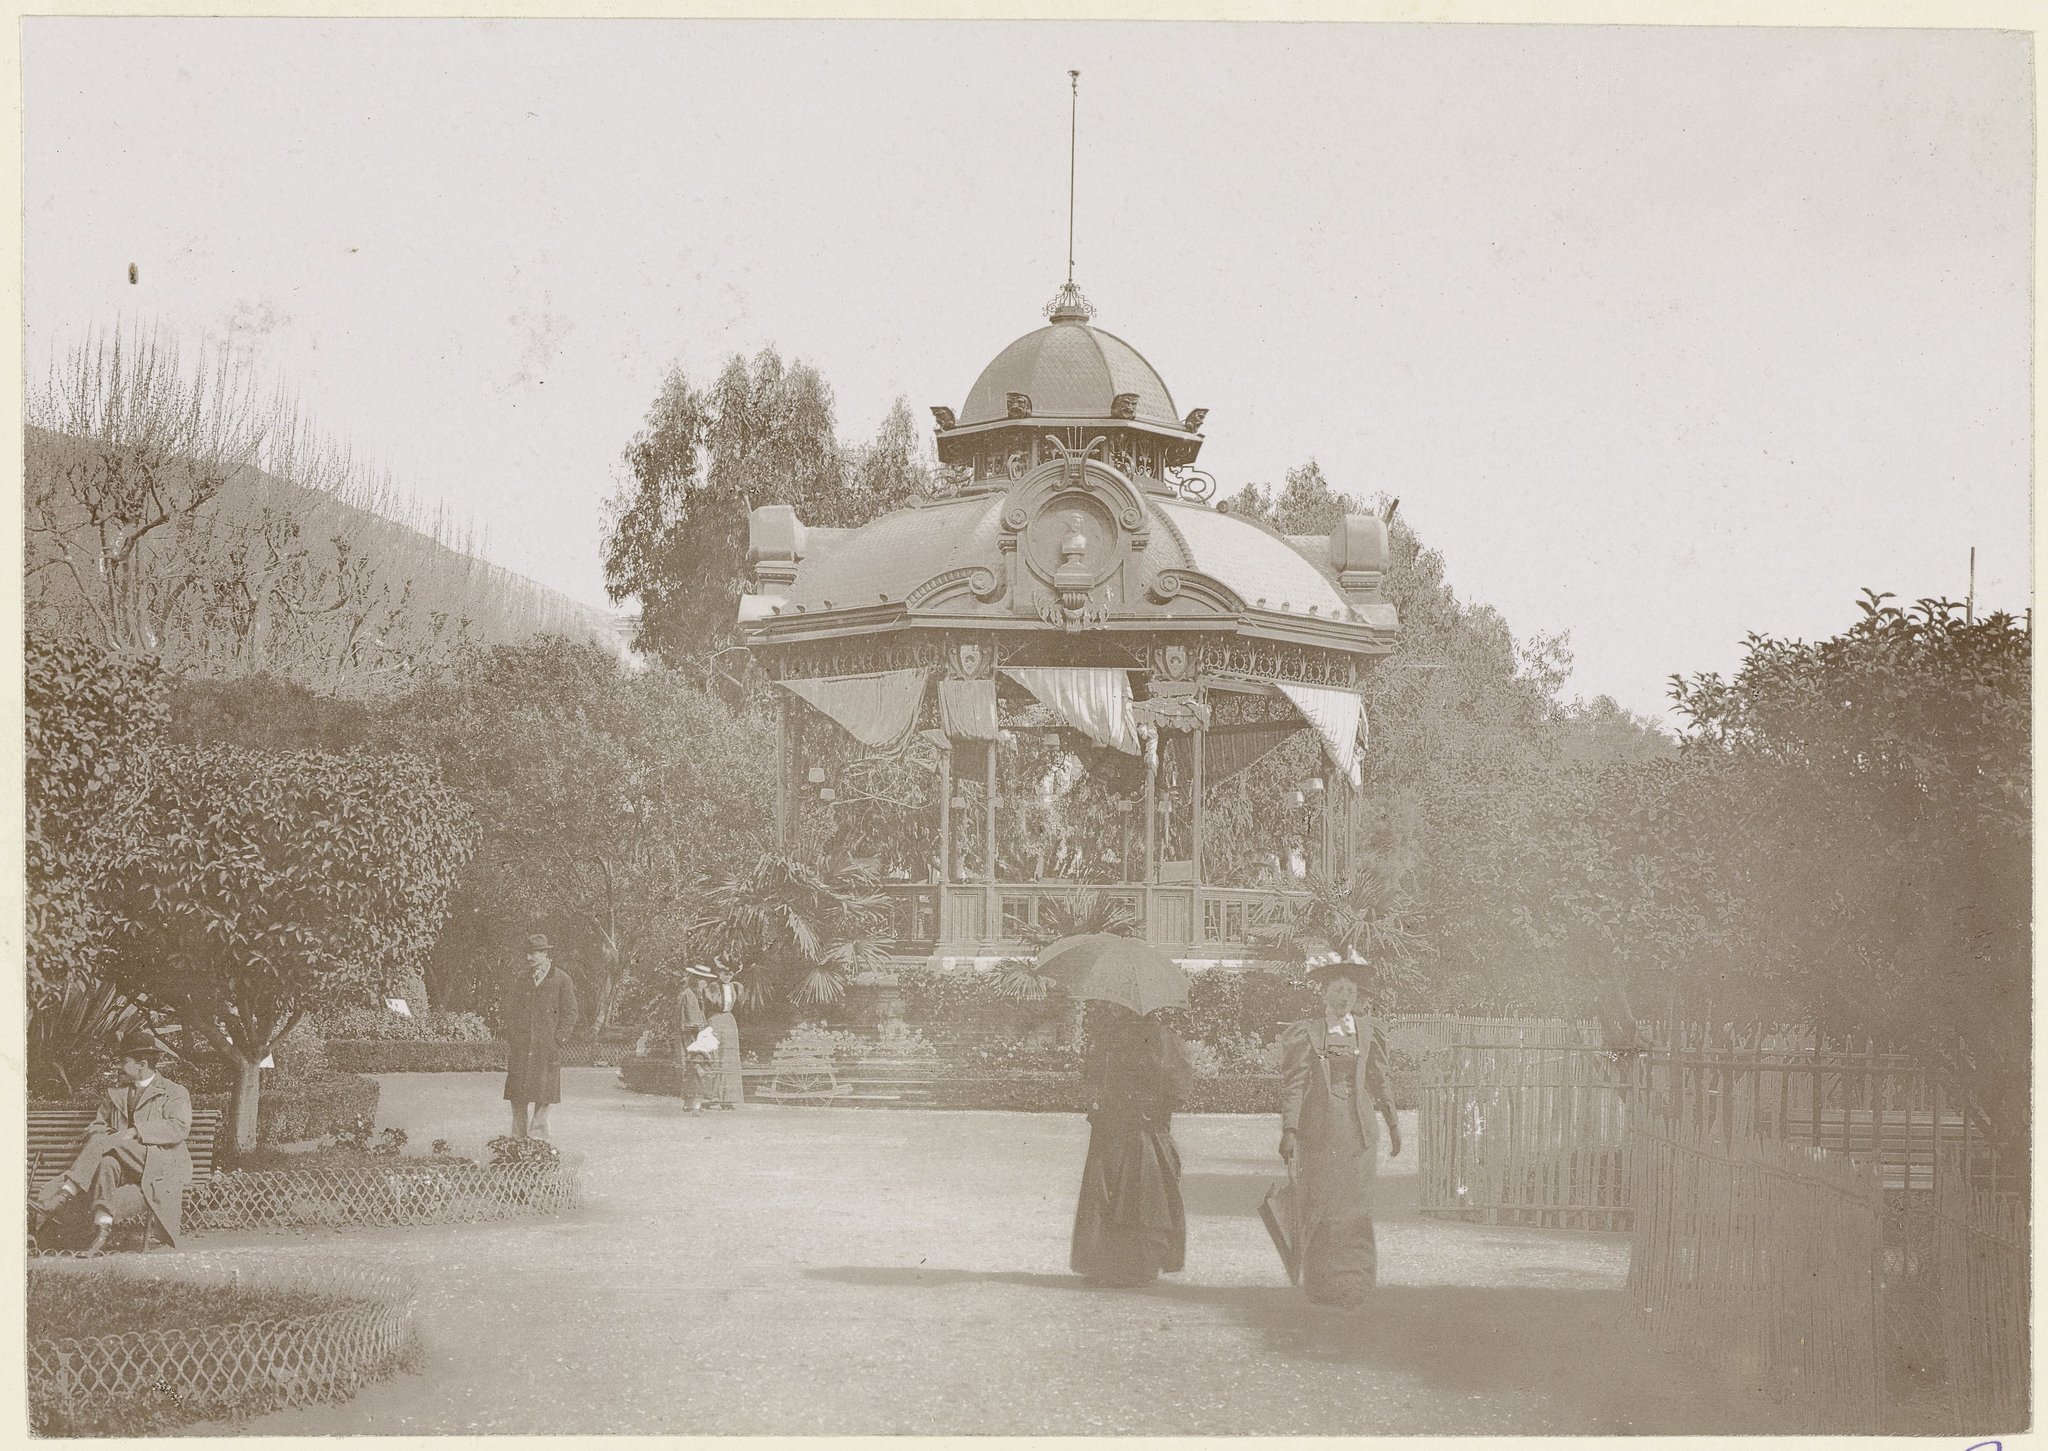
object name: photograph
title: Publieke stadstuin in Menton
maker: henry pauw van wieldrecht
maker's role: fotograaf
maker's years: 1863-1912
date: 1886-1896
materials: cardboard, photographic support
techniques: albumen print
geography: france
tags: menton